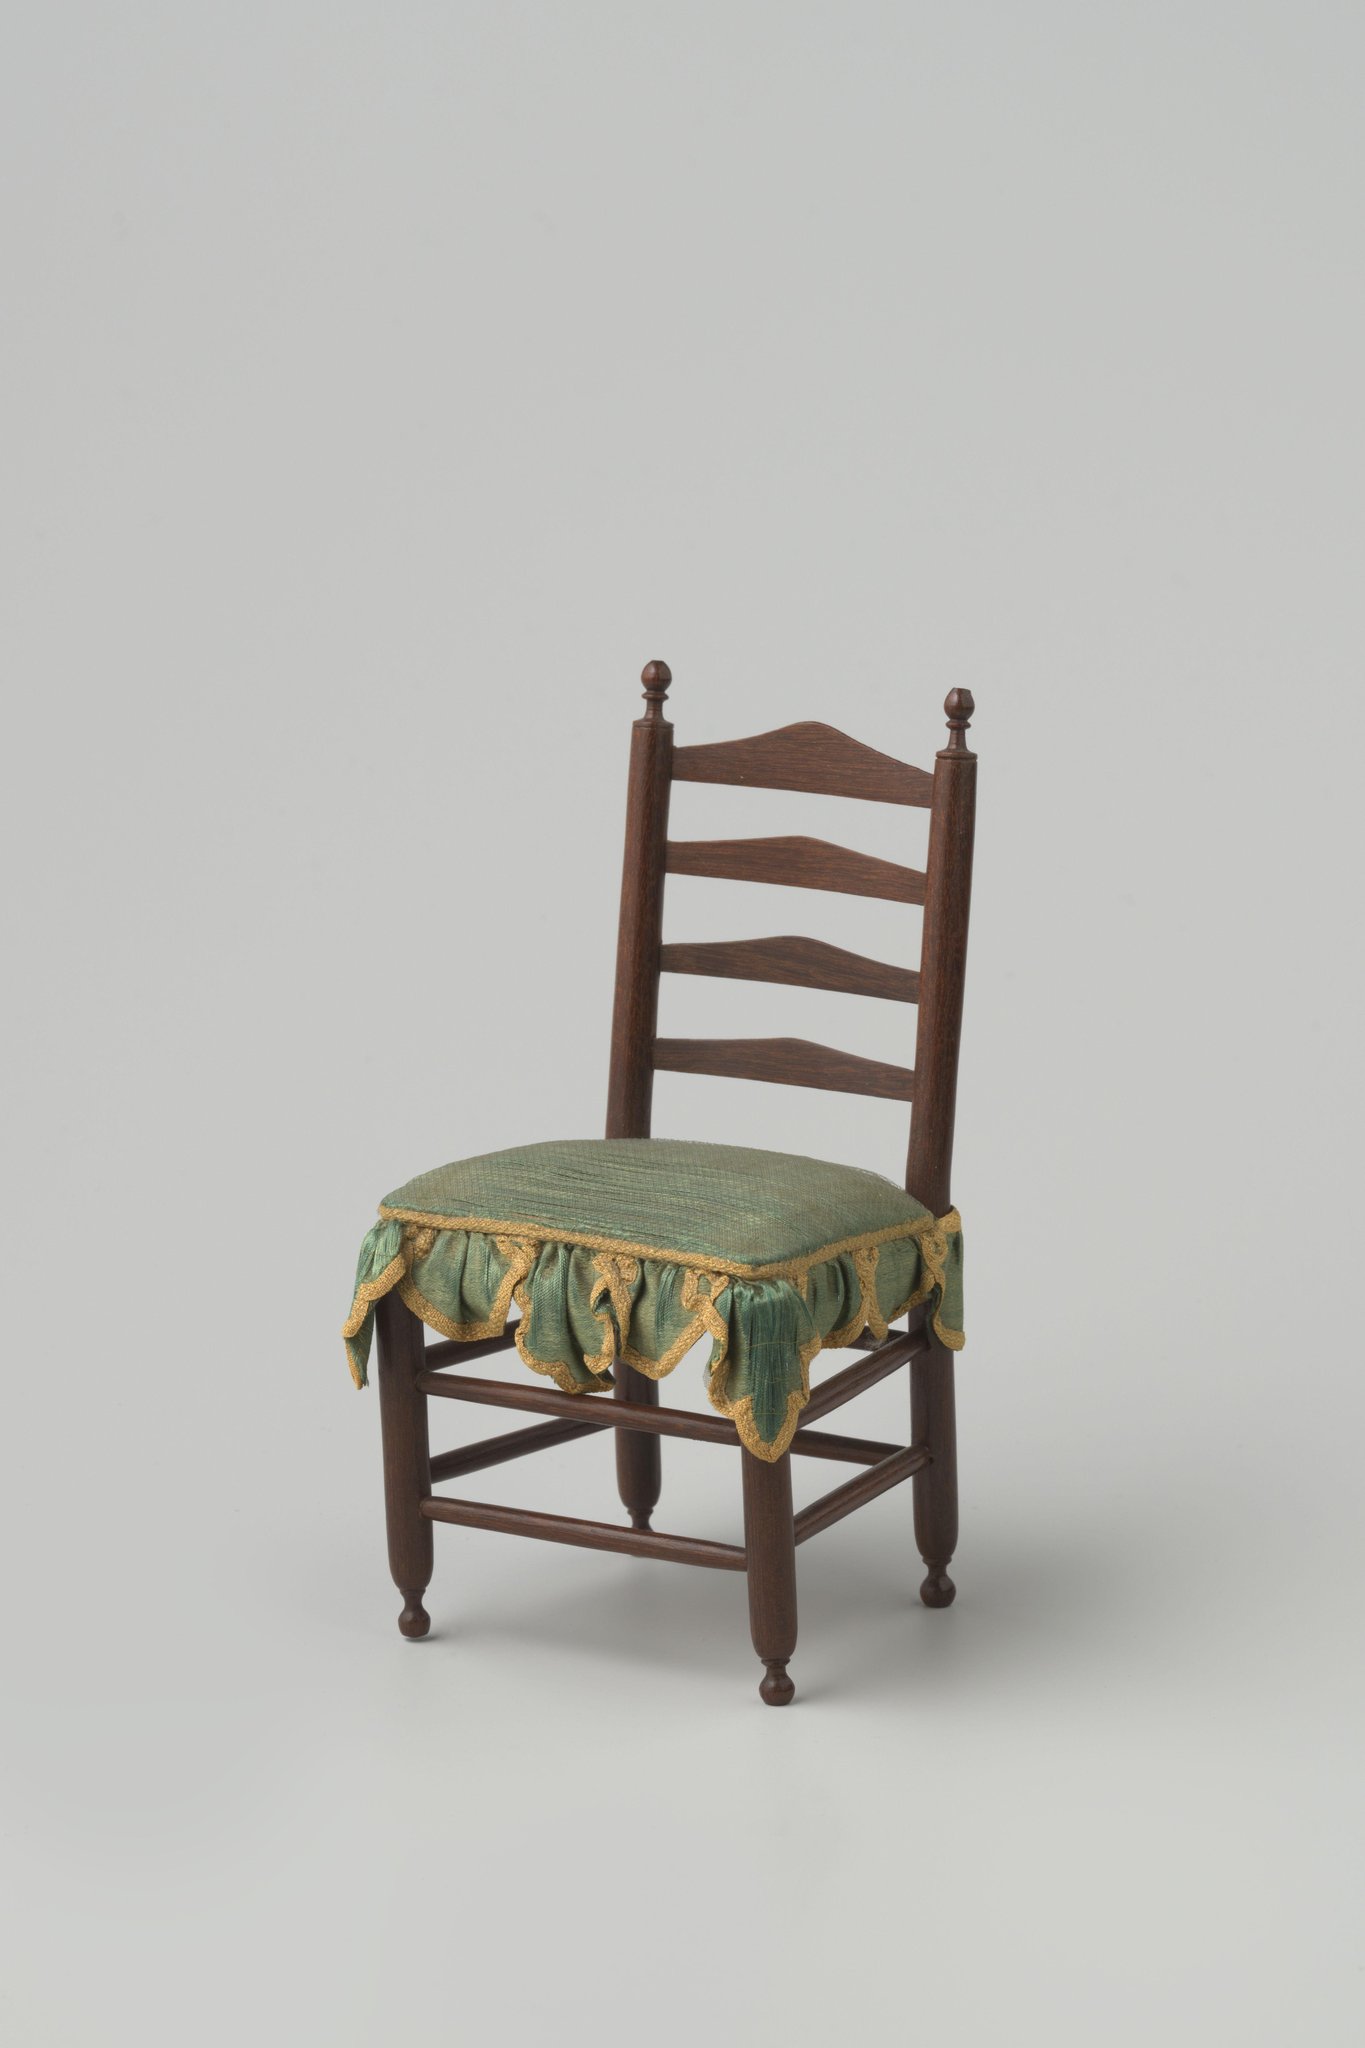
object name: chair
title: Knopstoel vervaardigd van hardhout met gladde, gedraaide stijlen en dwarsregels, voorpoten en achterstijlen eindigend in fijn gedraaide knoppen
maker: Anonymous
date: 1690-1710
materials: wood, silk, fiber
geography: amsterdam